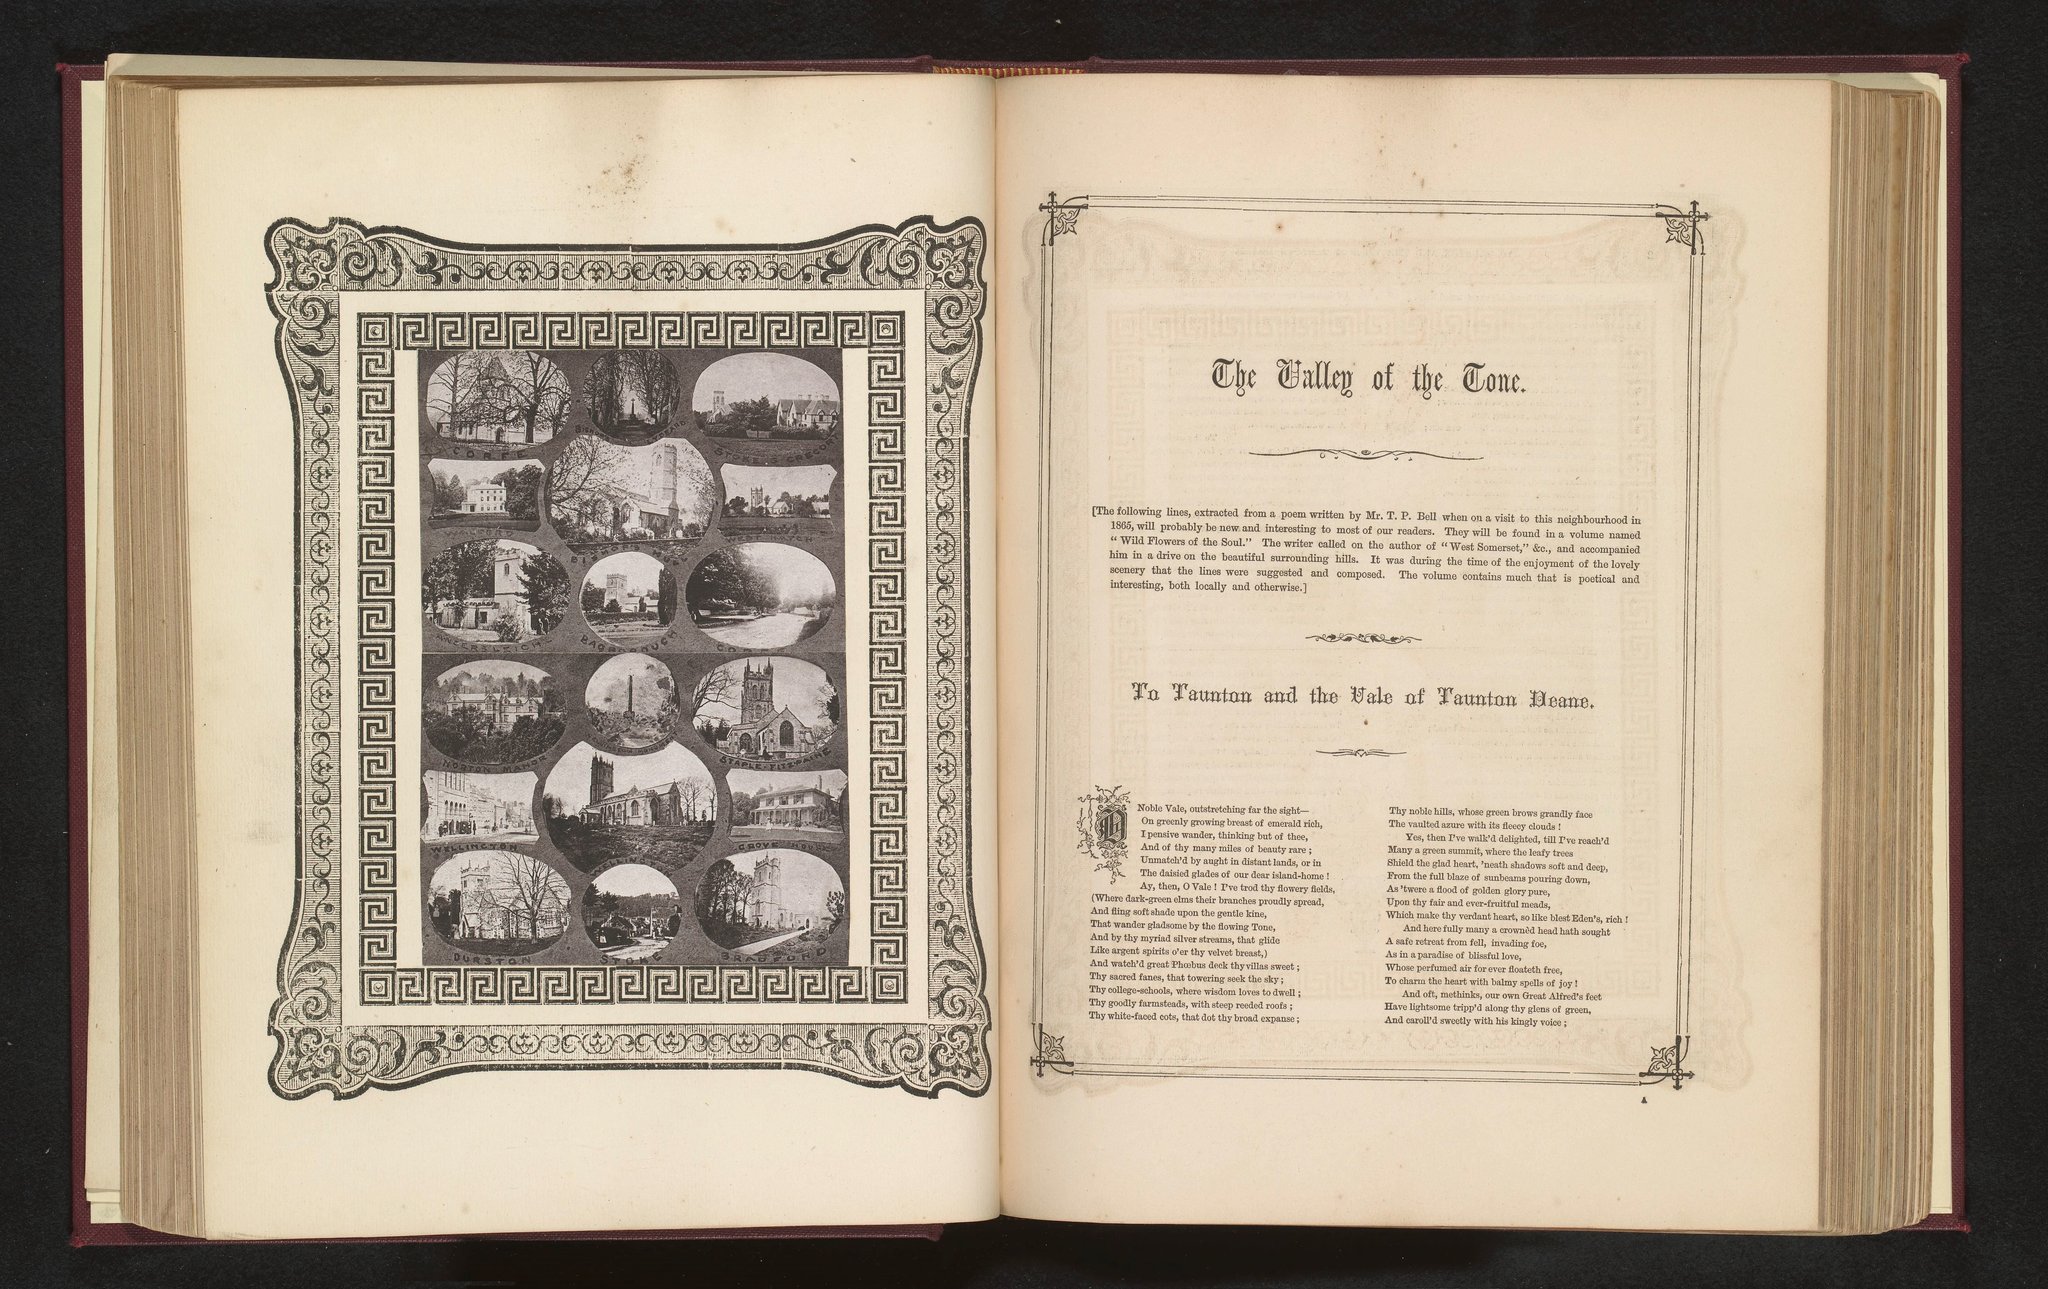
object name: page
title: Achttien gezichten op kerken en gebouwen in West Dorset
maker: Anonymous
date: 1868-1873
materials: paper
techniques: photoaquatint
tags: church (exterior), exterior ~ representation of a building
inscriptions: inscription: ‘Corfe (...) Bradford’